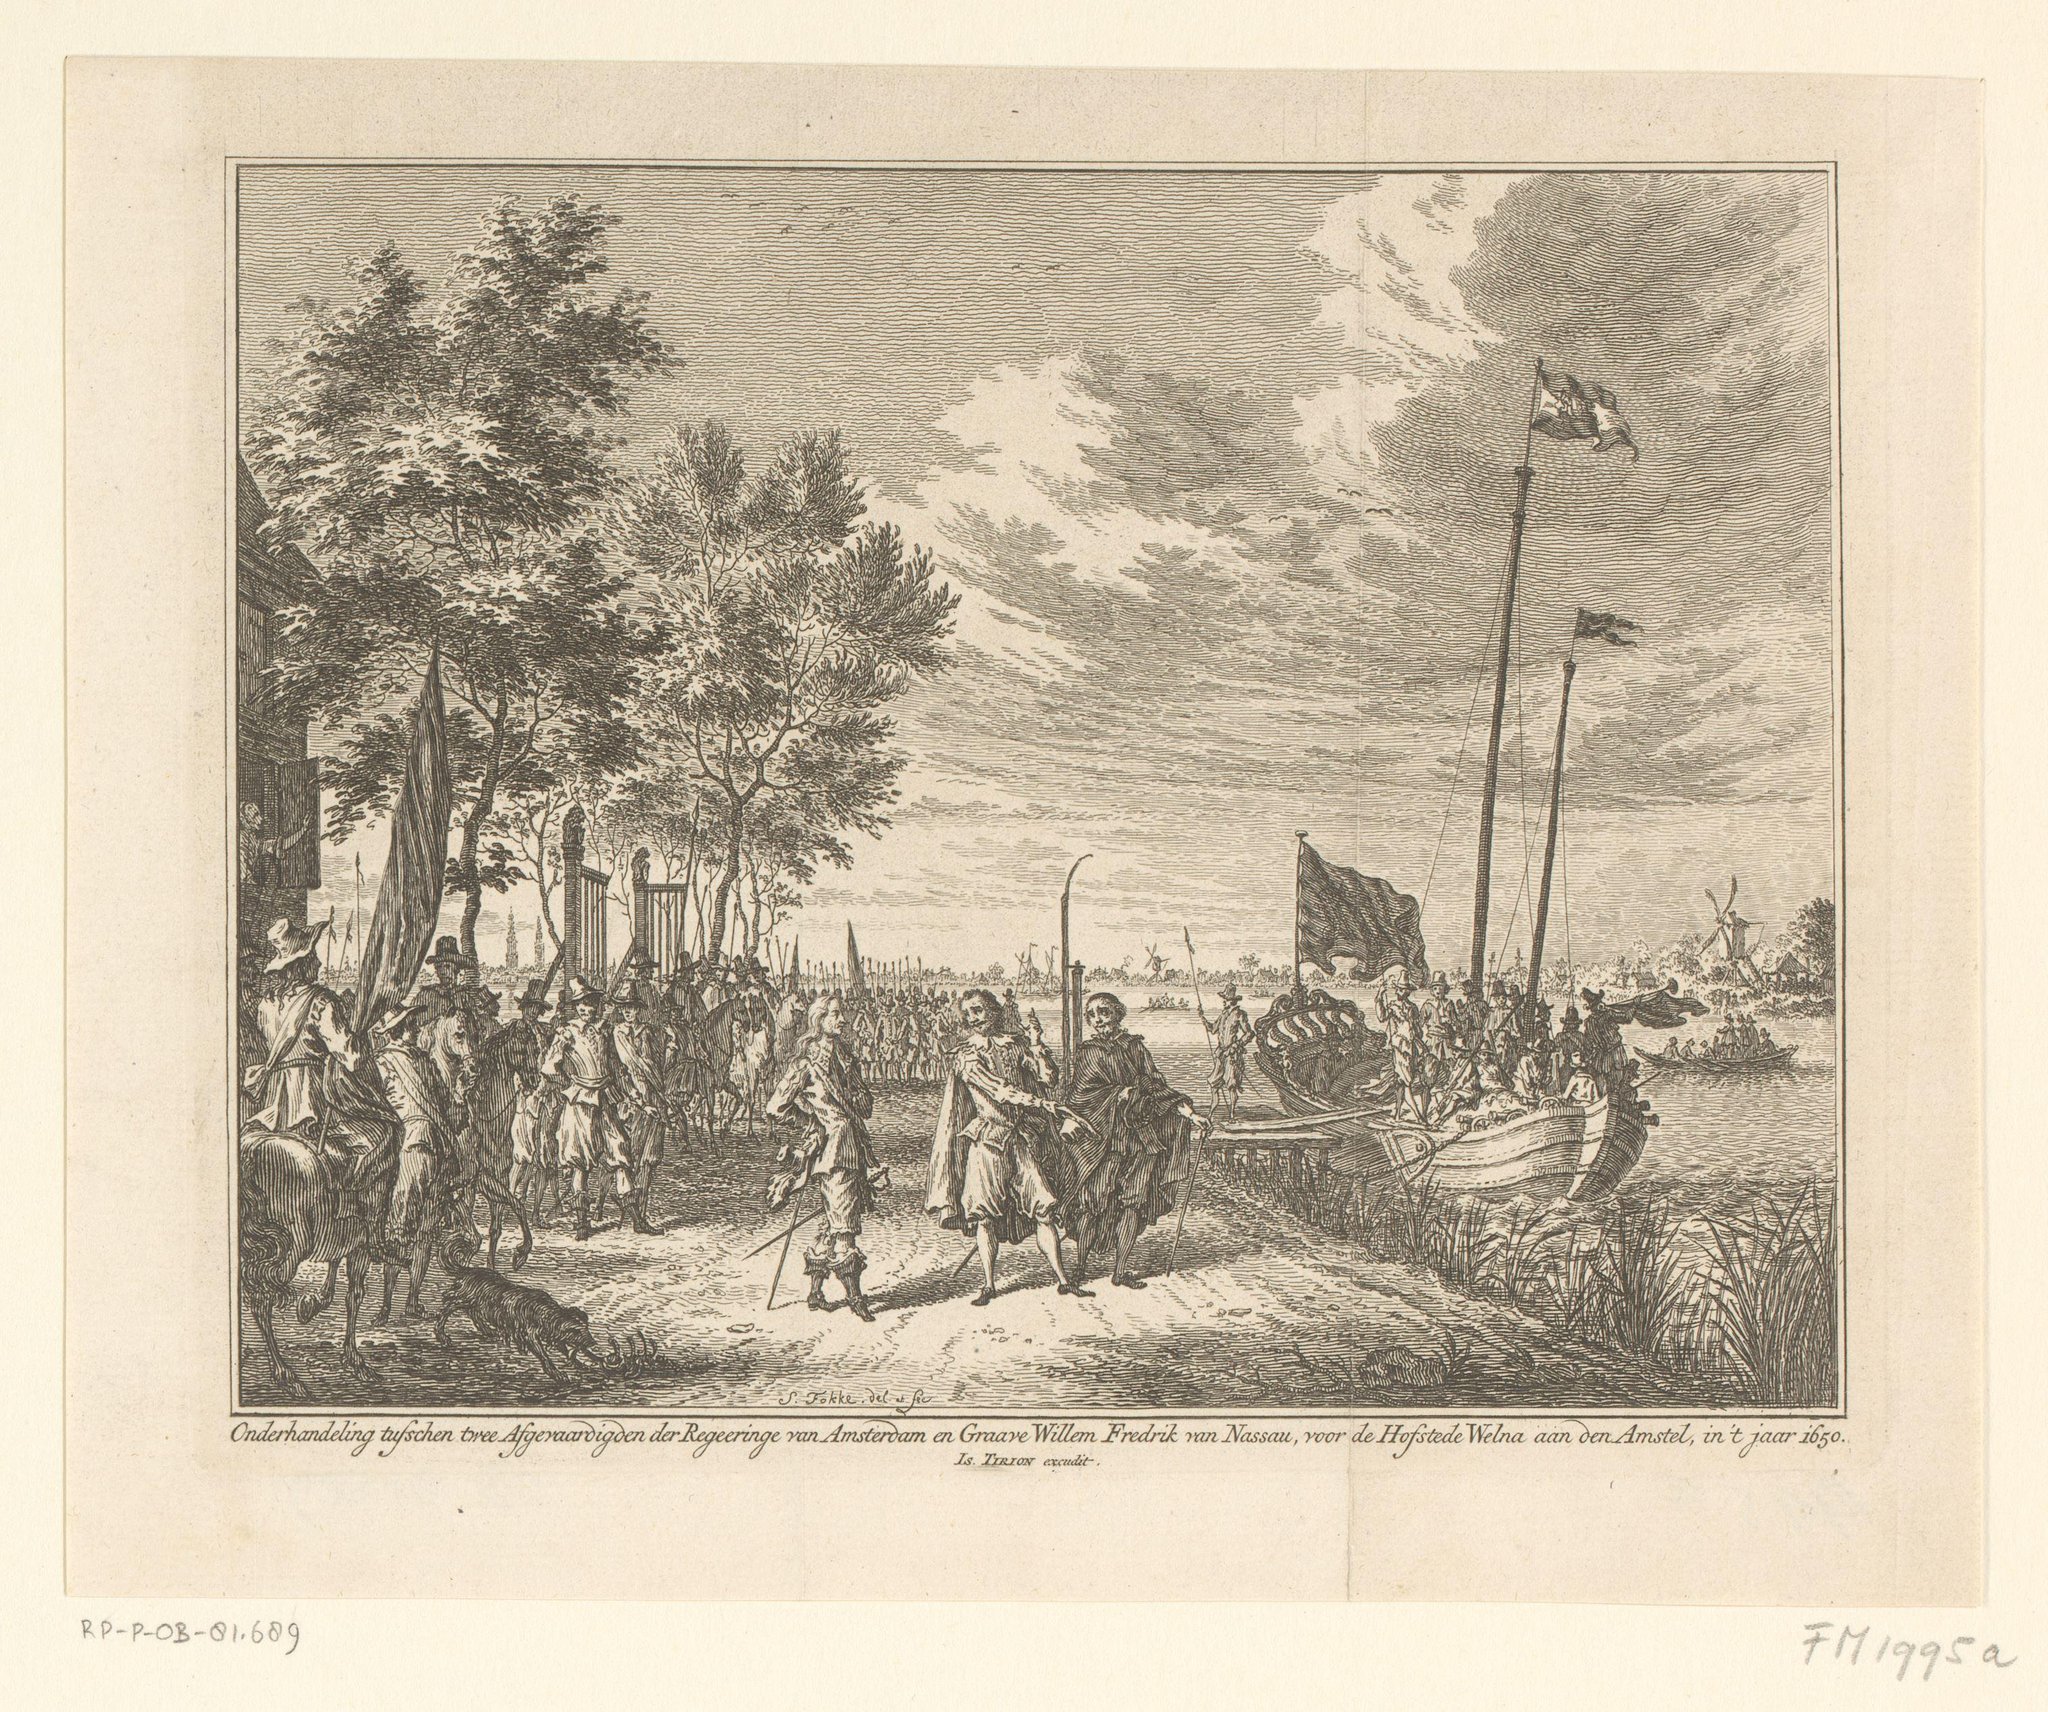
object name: history print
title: Onderhandeling tussen afgevaardigden van Amsterdam en graaf Willem Frederik bij Hofstede Welna aan de Amstel, 1650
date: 1747-1759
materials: paper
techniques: etching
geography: northern netherlands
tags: arnhem, william ii (prince of orange), peace negotiations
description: Onderhandeling tussen twee afgevaardigden van de stad Amsterdam en stadhouder Willem Frederik voor Hofstede Welna aan de Amstel, 29-30 juli 1650. Rechts het Statenjacht.